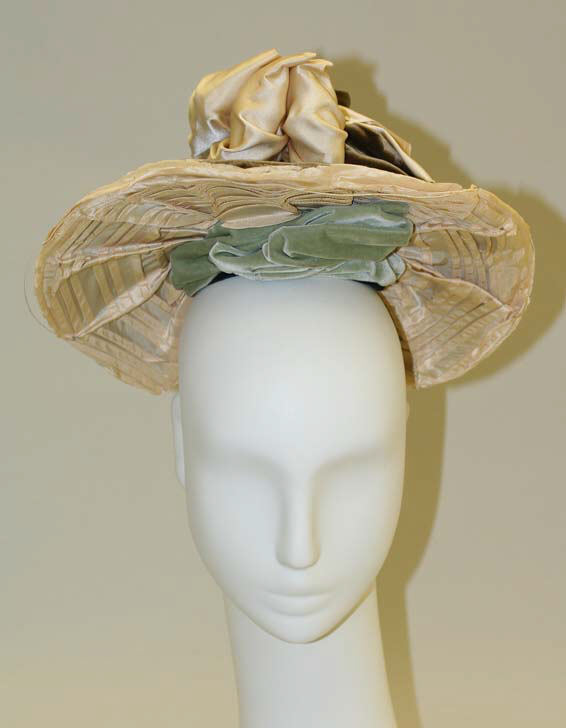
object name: hat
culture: american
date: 1892-1893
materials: cotton, metal, silk